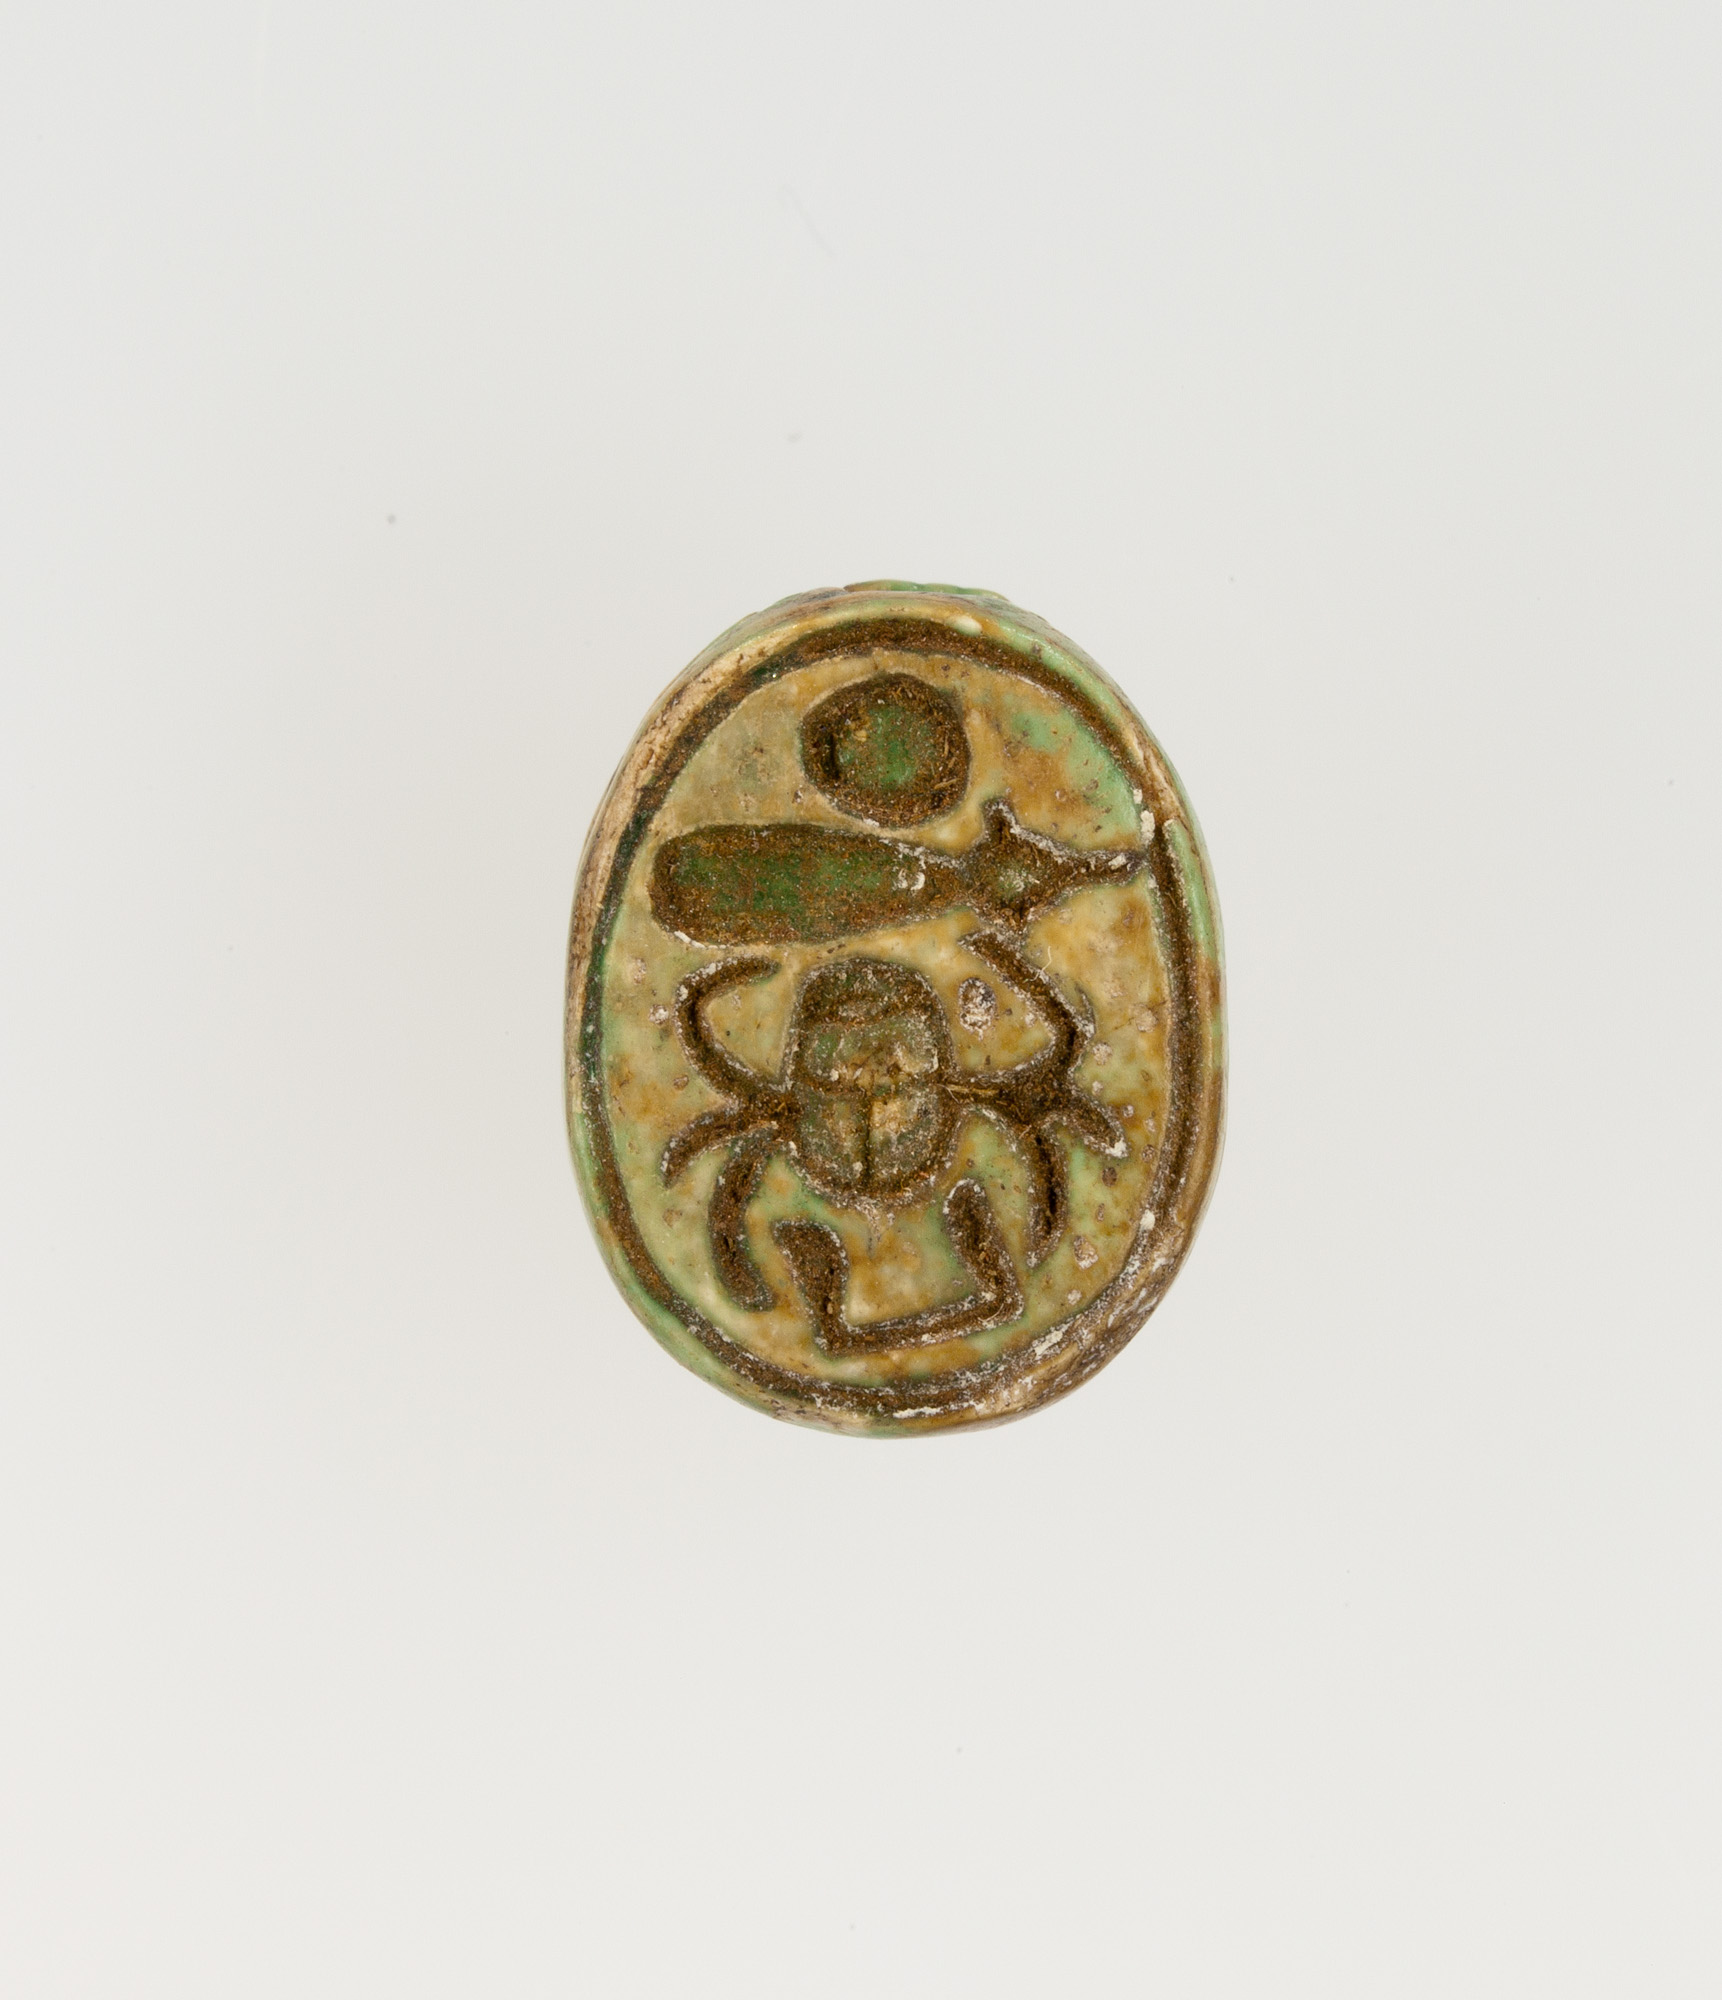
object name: scarab, thutmose i, aakheperkare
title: Scarab Inscribed with the Throne Name of Thutmose I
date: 1504-1492 BCE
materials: stone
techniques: glazing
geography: egypt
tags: hieroglyphs,scarabs